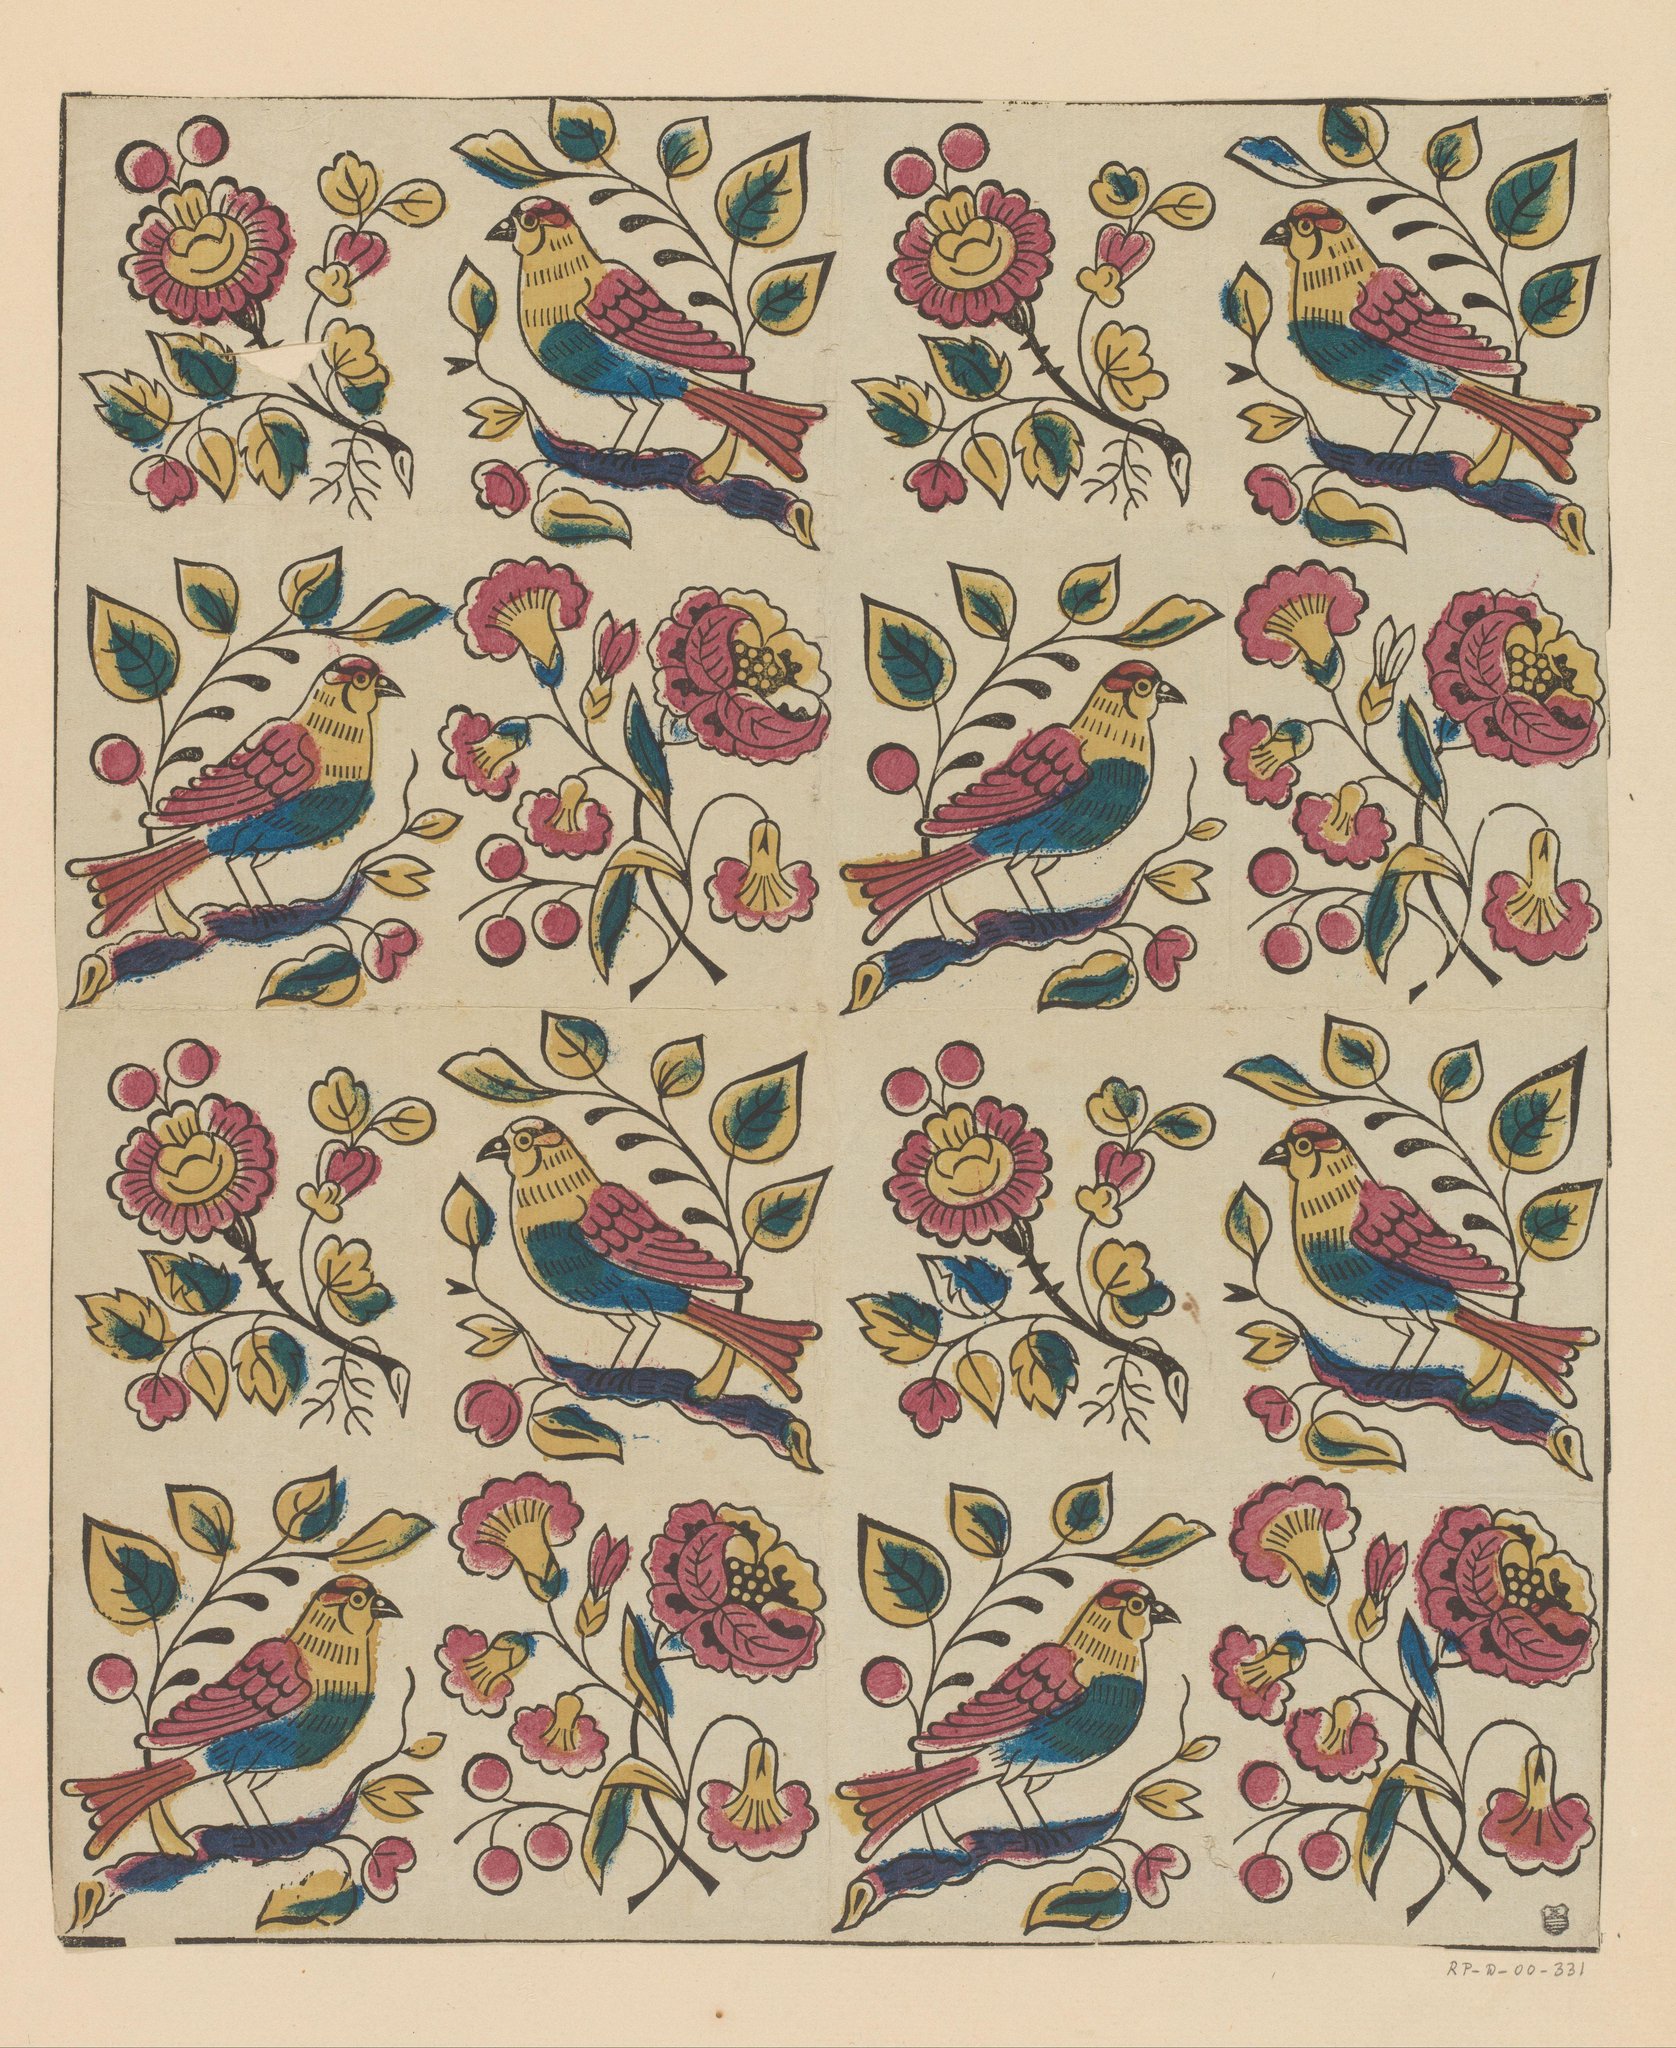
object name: printed paper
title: Blad met vier rijen met afwisselend bloemen en vogels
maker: Anonymous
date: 1700-1850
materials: paper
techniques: printing block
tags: ornament derived from animal forms, birds, ornament derived from plant forms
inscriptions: collector's mark: Lugt 2760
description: Blad met vier rijen van vier afwisselend takje met bloem en vrucht, en vogel op tak.